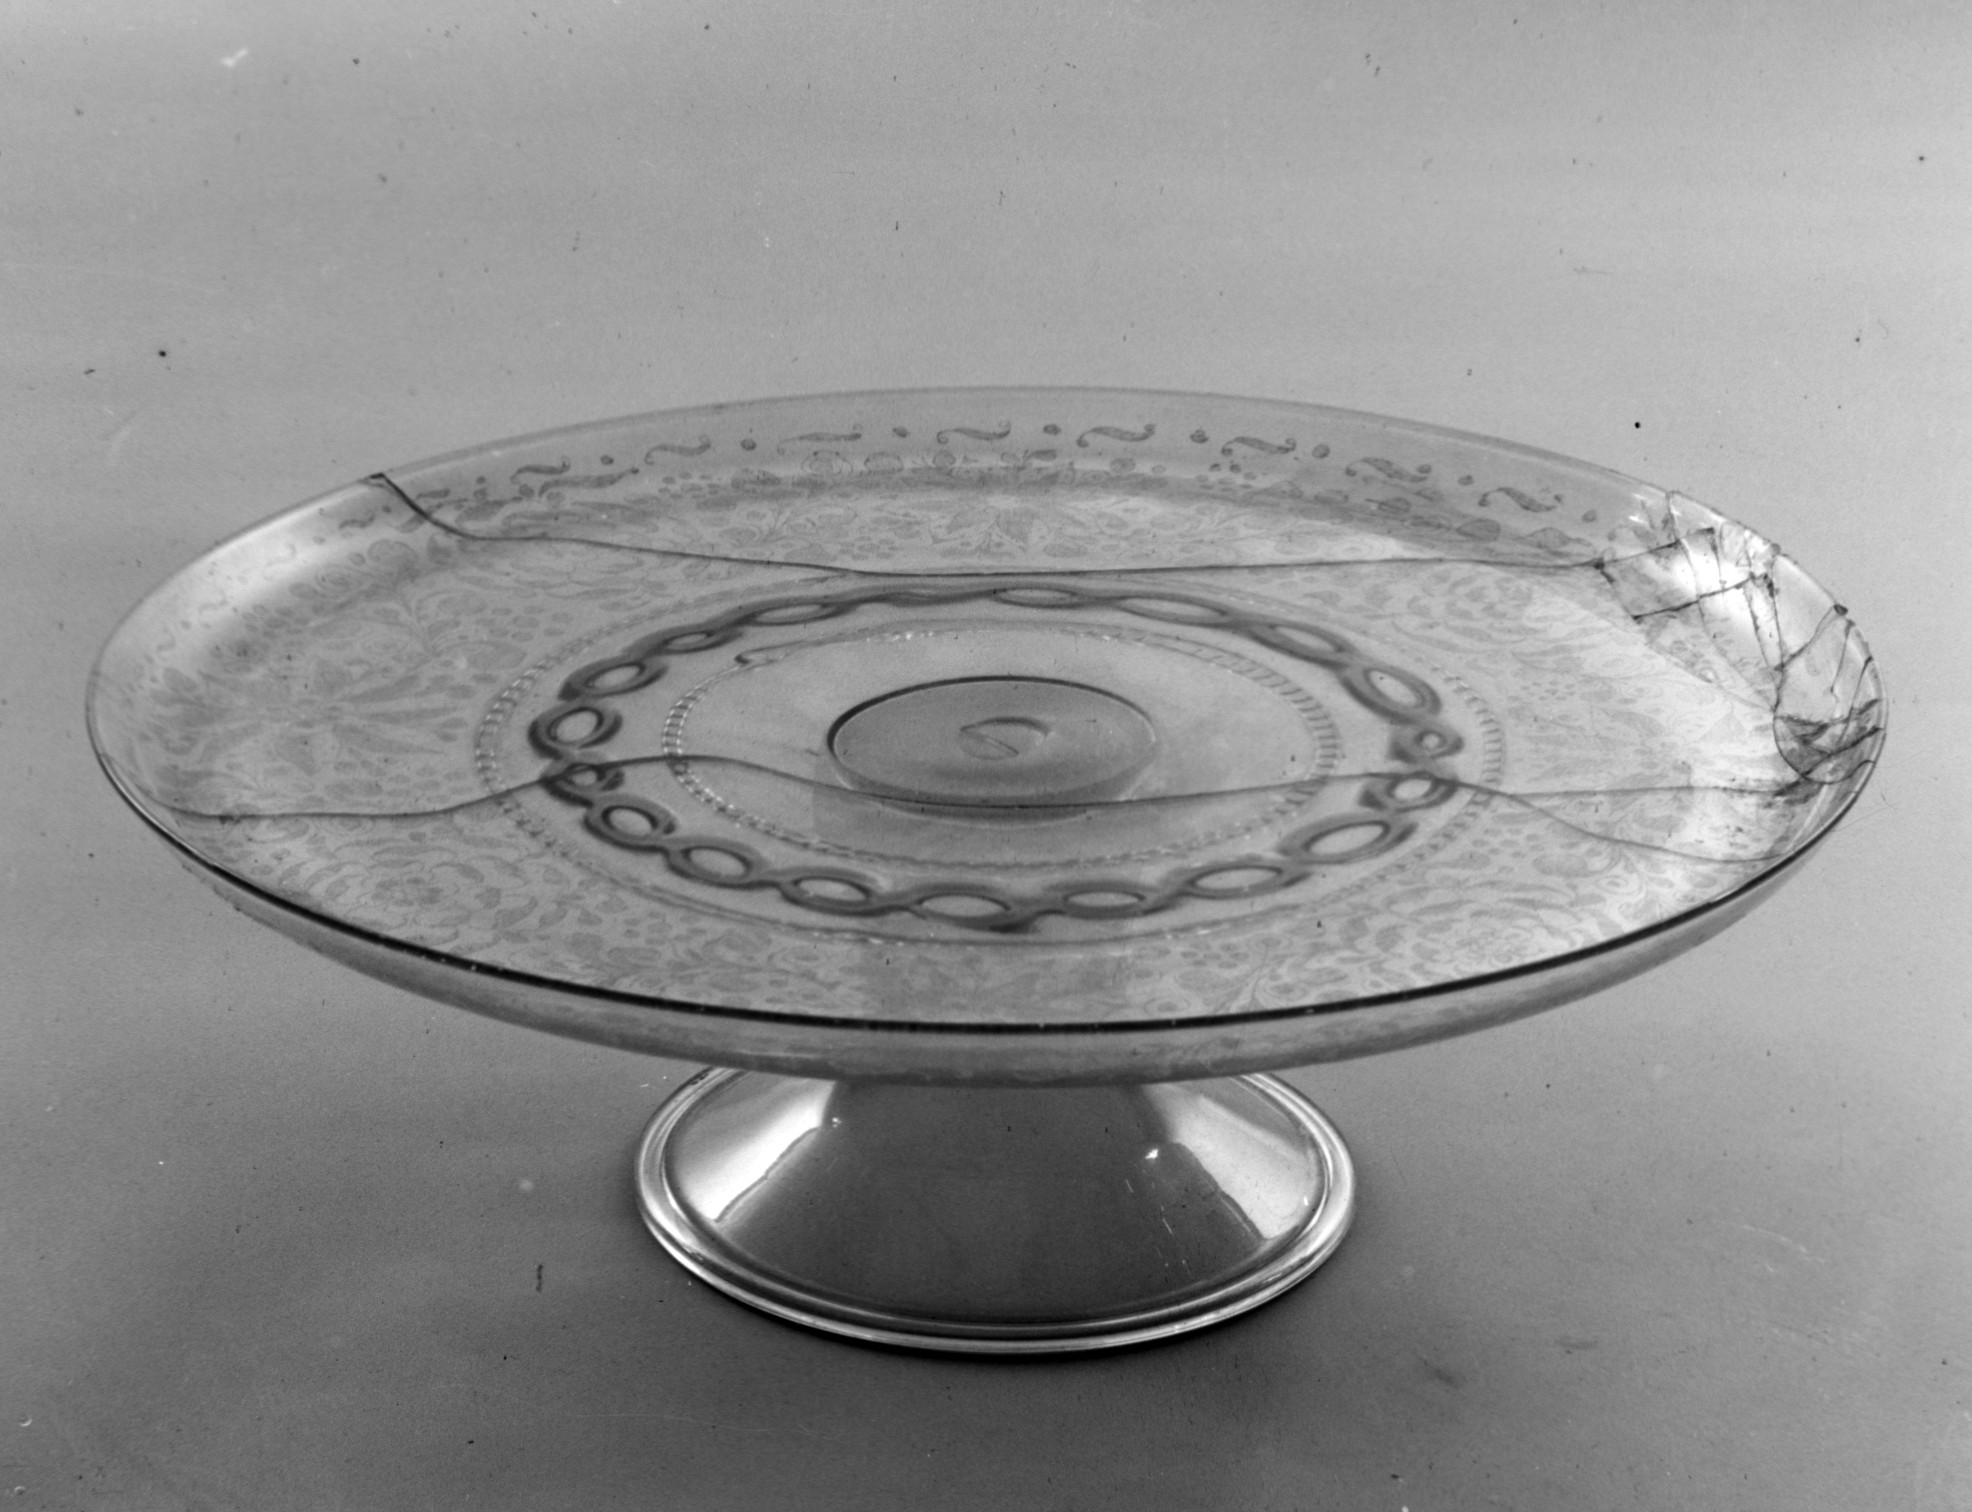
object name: tazza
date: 1600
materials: glass